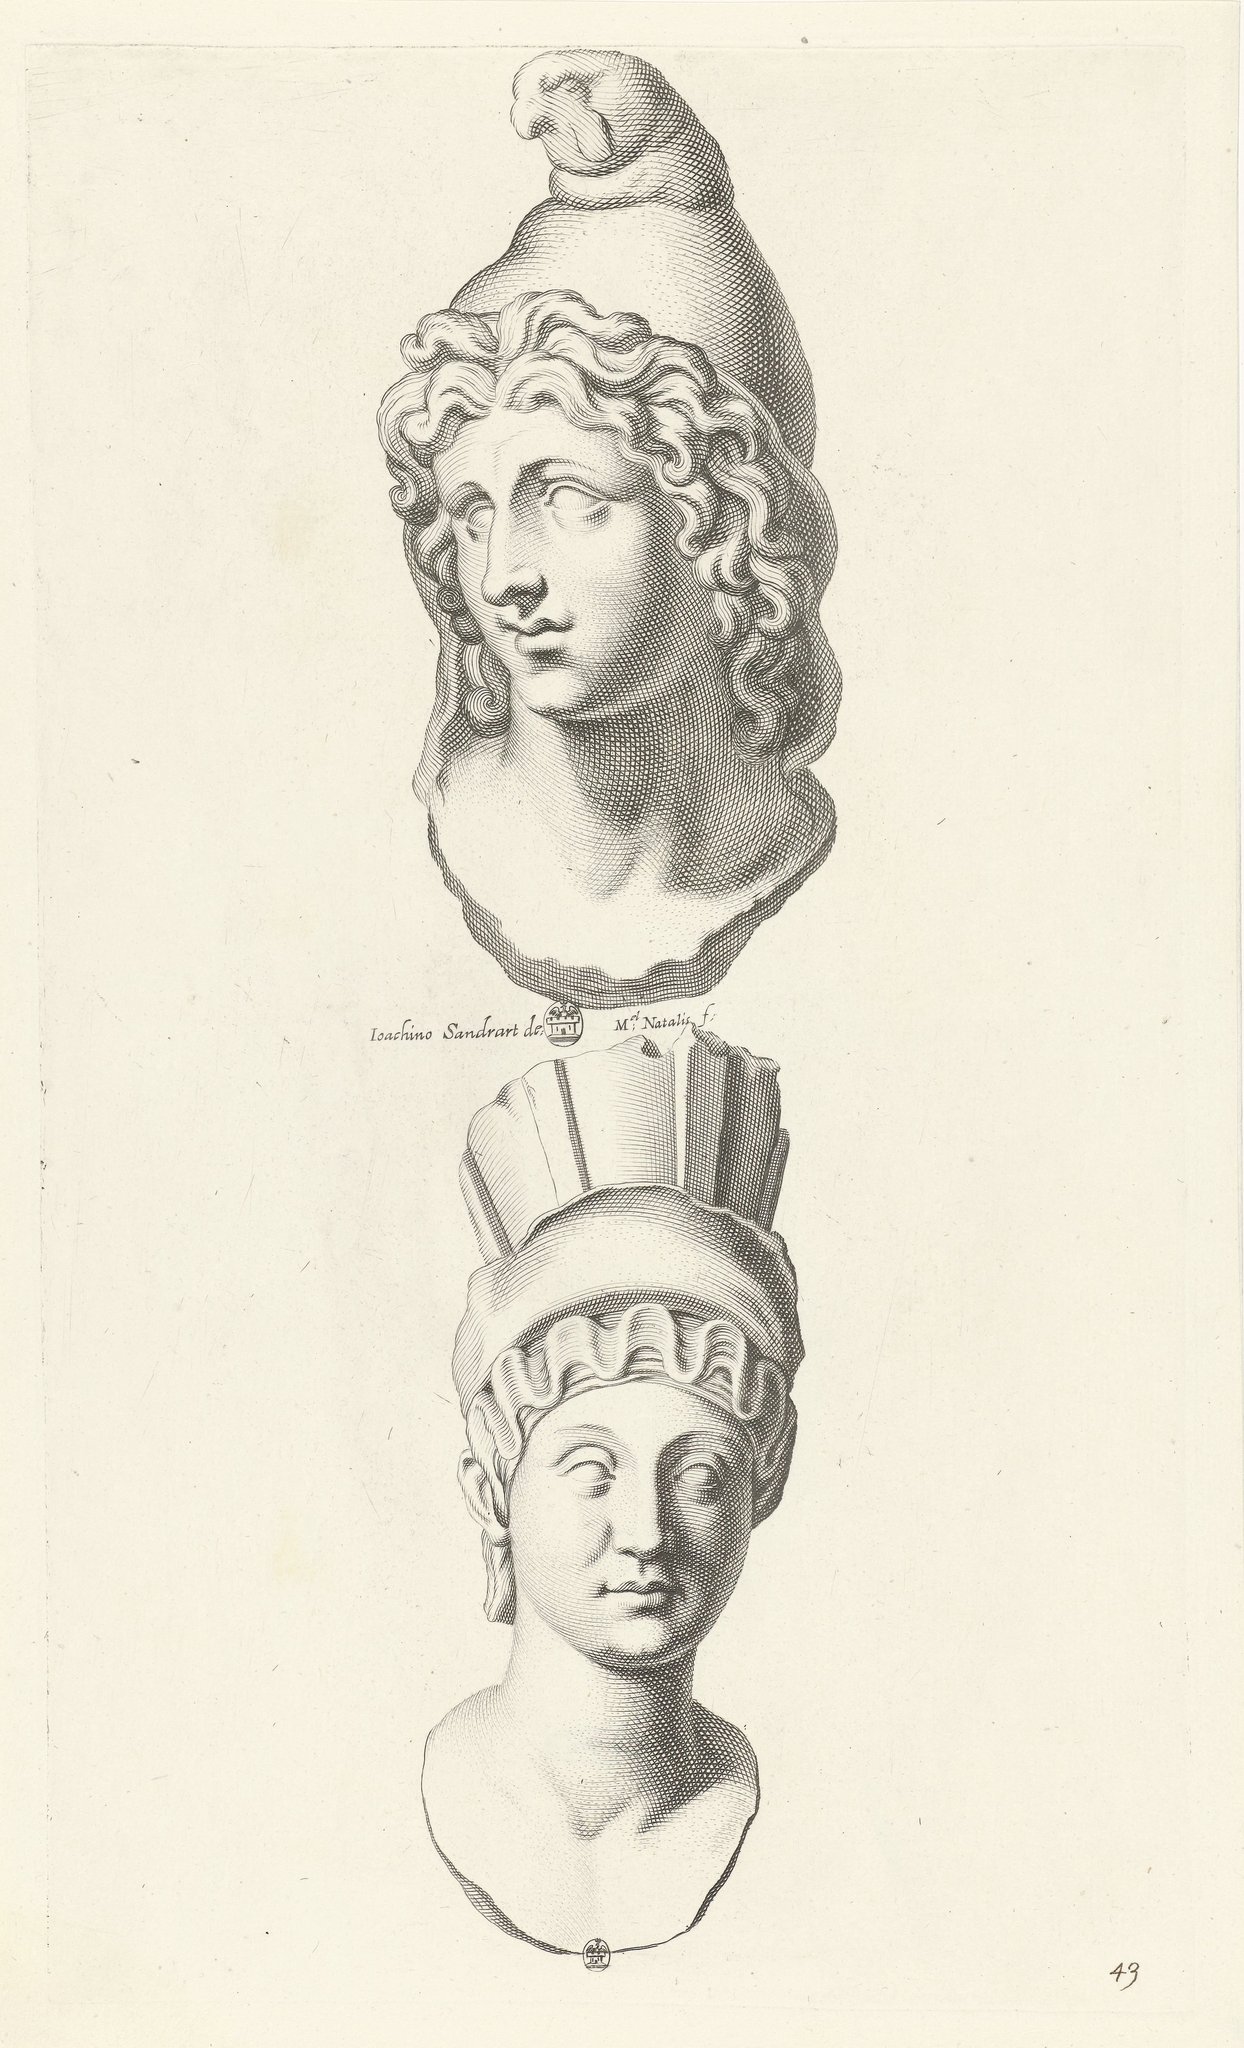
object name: print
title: Portretten van Paris en Cybele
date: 1640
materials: paper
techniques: engraving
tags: rome, vincenzo giustiniani (1564-1637), male persons from classical history (+ head, bust, etc.), female persons from classical history (+ head, bust, etc.), (story of) cybele, rhea cybele, great mother of the gods (berecynt(h)ia), piece of sculpture, reproduction of a piece of sculpture, phrygian bonnet, (story of) paris (alexander)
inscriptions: collector's mark: Lugt 2228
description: Twee Romeinse sculpturen. Boven het portret van Paris met een Frygische muts op het hoofd. Onder het portret van Cybele met de muurkroon op haar hoofd. Midden onder de beelden het wapenschild van Vincenzo Giustiniani. Prent uit een serie naar de sculpturen in de verzameling in de Galleria Giustiniani te Rome.